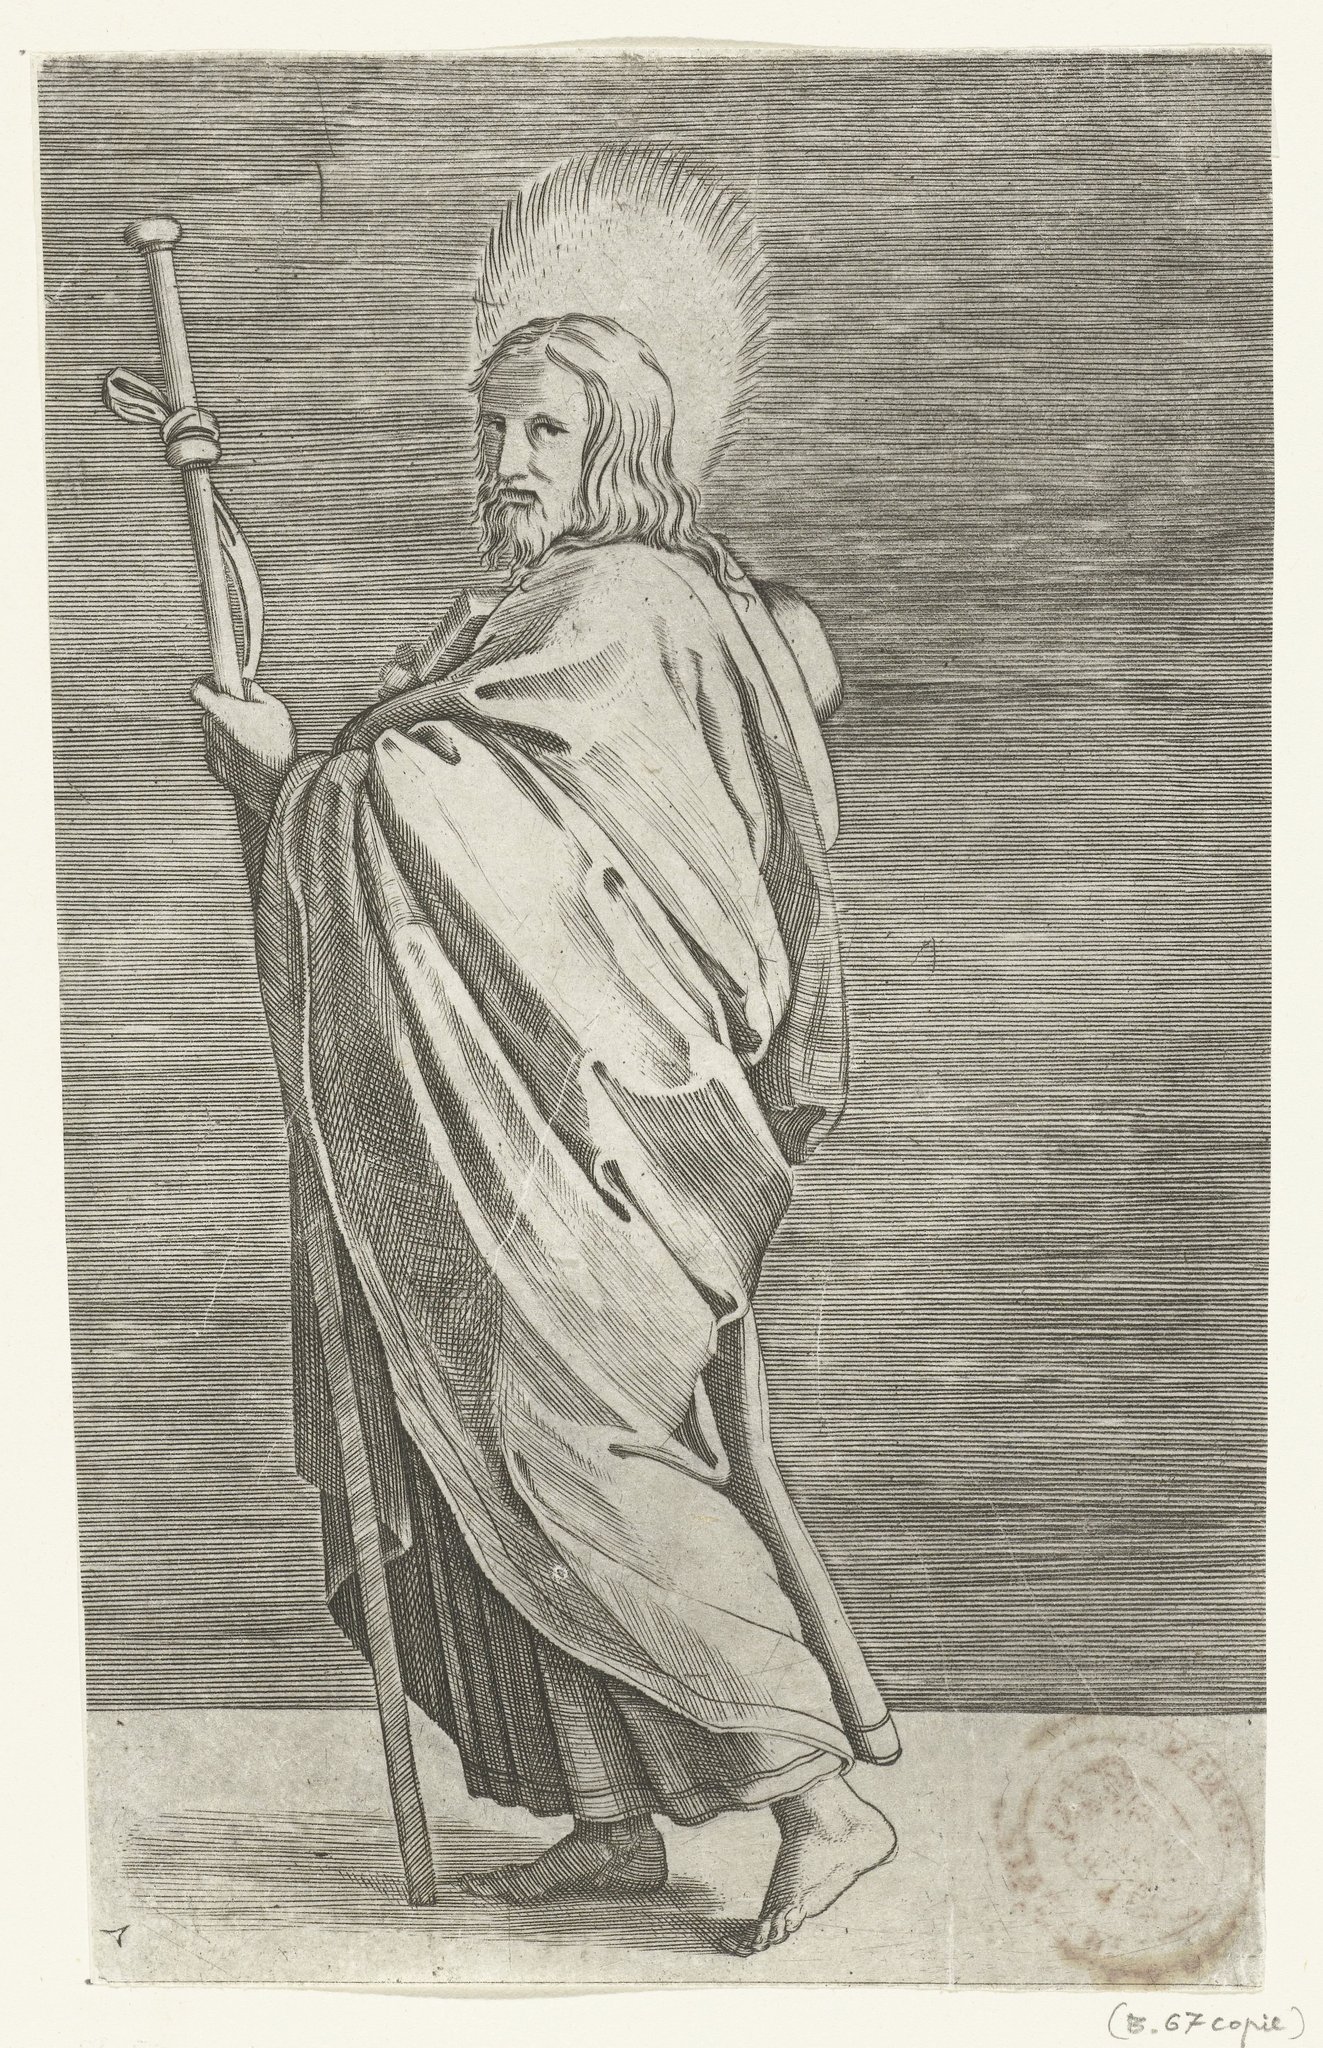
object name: print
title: Apostel Jakobus de Meerdere (Major) met pelgrimshoed en pelgrimsstaf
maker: marco dente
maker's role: print maker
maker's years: 1486-1527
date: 1517-1527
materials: paper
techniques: engraving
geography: italy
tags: the apostle james the great; possible attributes: book, pilgrim's cloak, hat, shell, staff, and wallet, scroll, sword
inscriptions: collector's mark: Lugt 240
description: Kopie naar prent van Marcantonio Raimondi. Raimondi op zijn beurt gebruikte een ontwerp van Raphael als voorbeeld. Linksonder is vaag nog een klein driehoekje zichtbaar dat de hier afgesneden monogram van Marco Dente flankeerde.